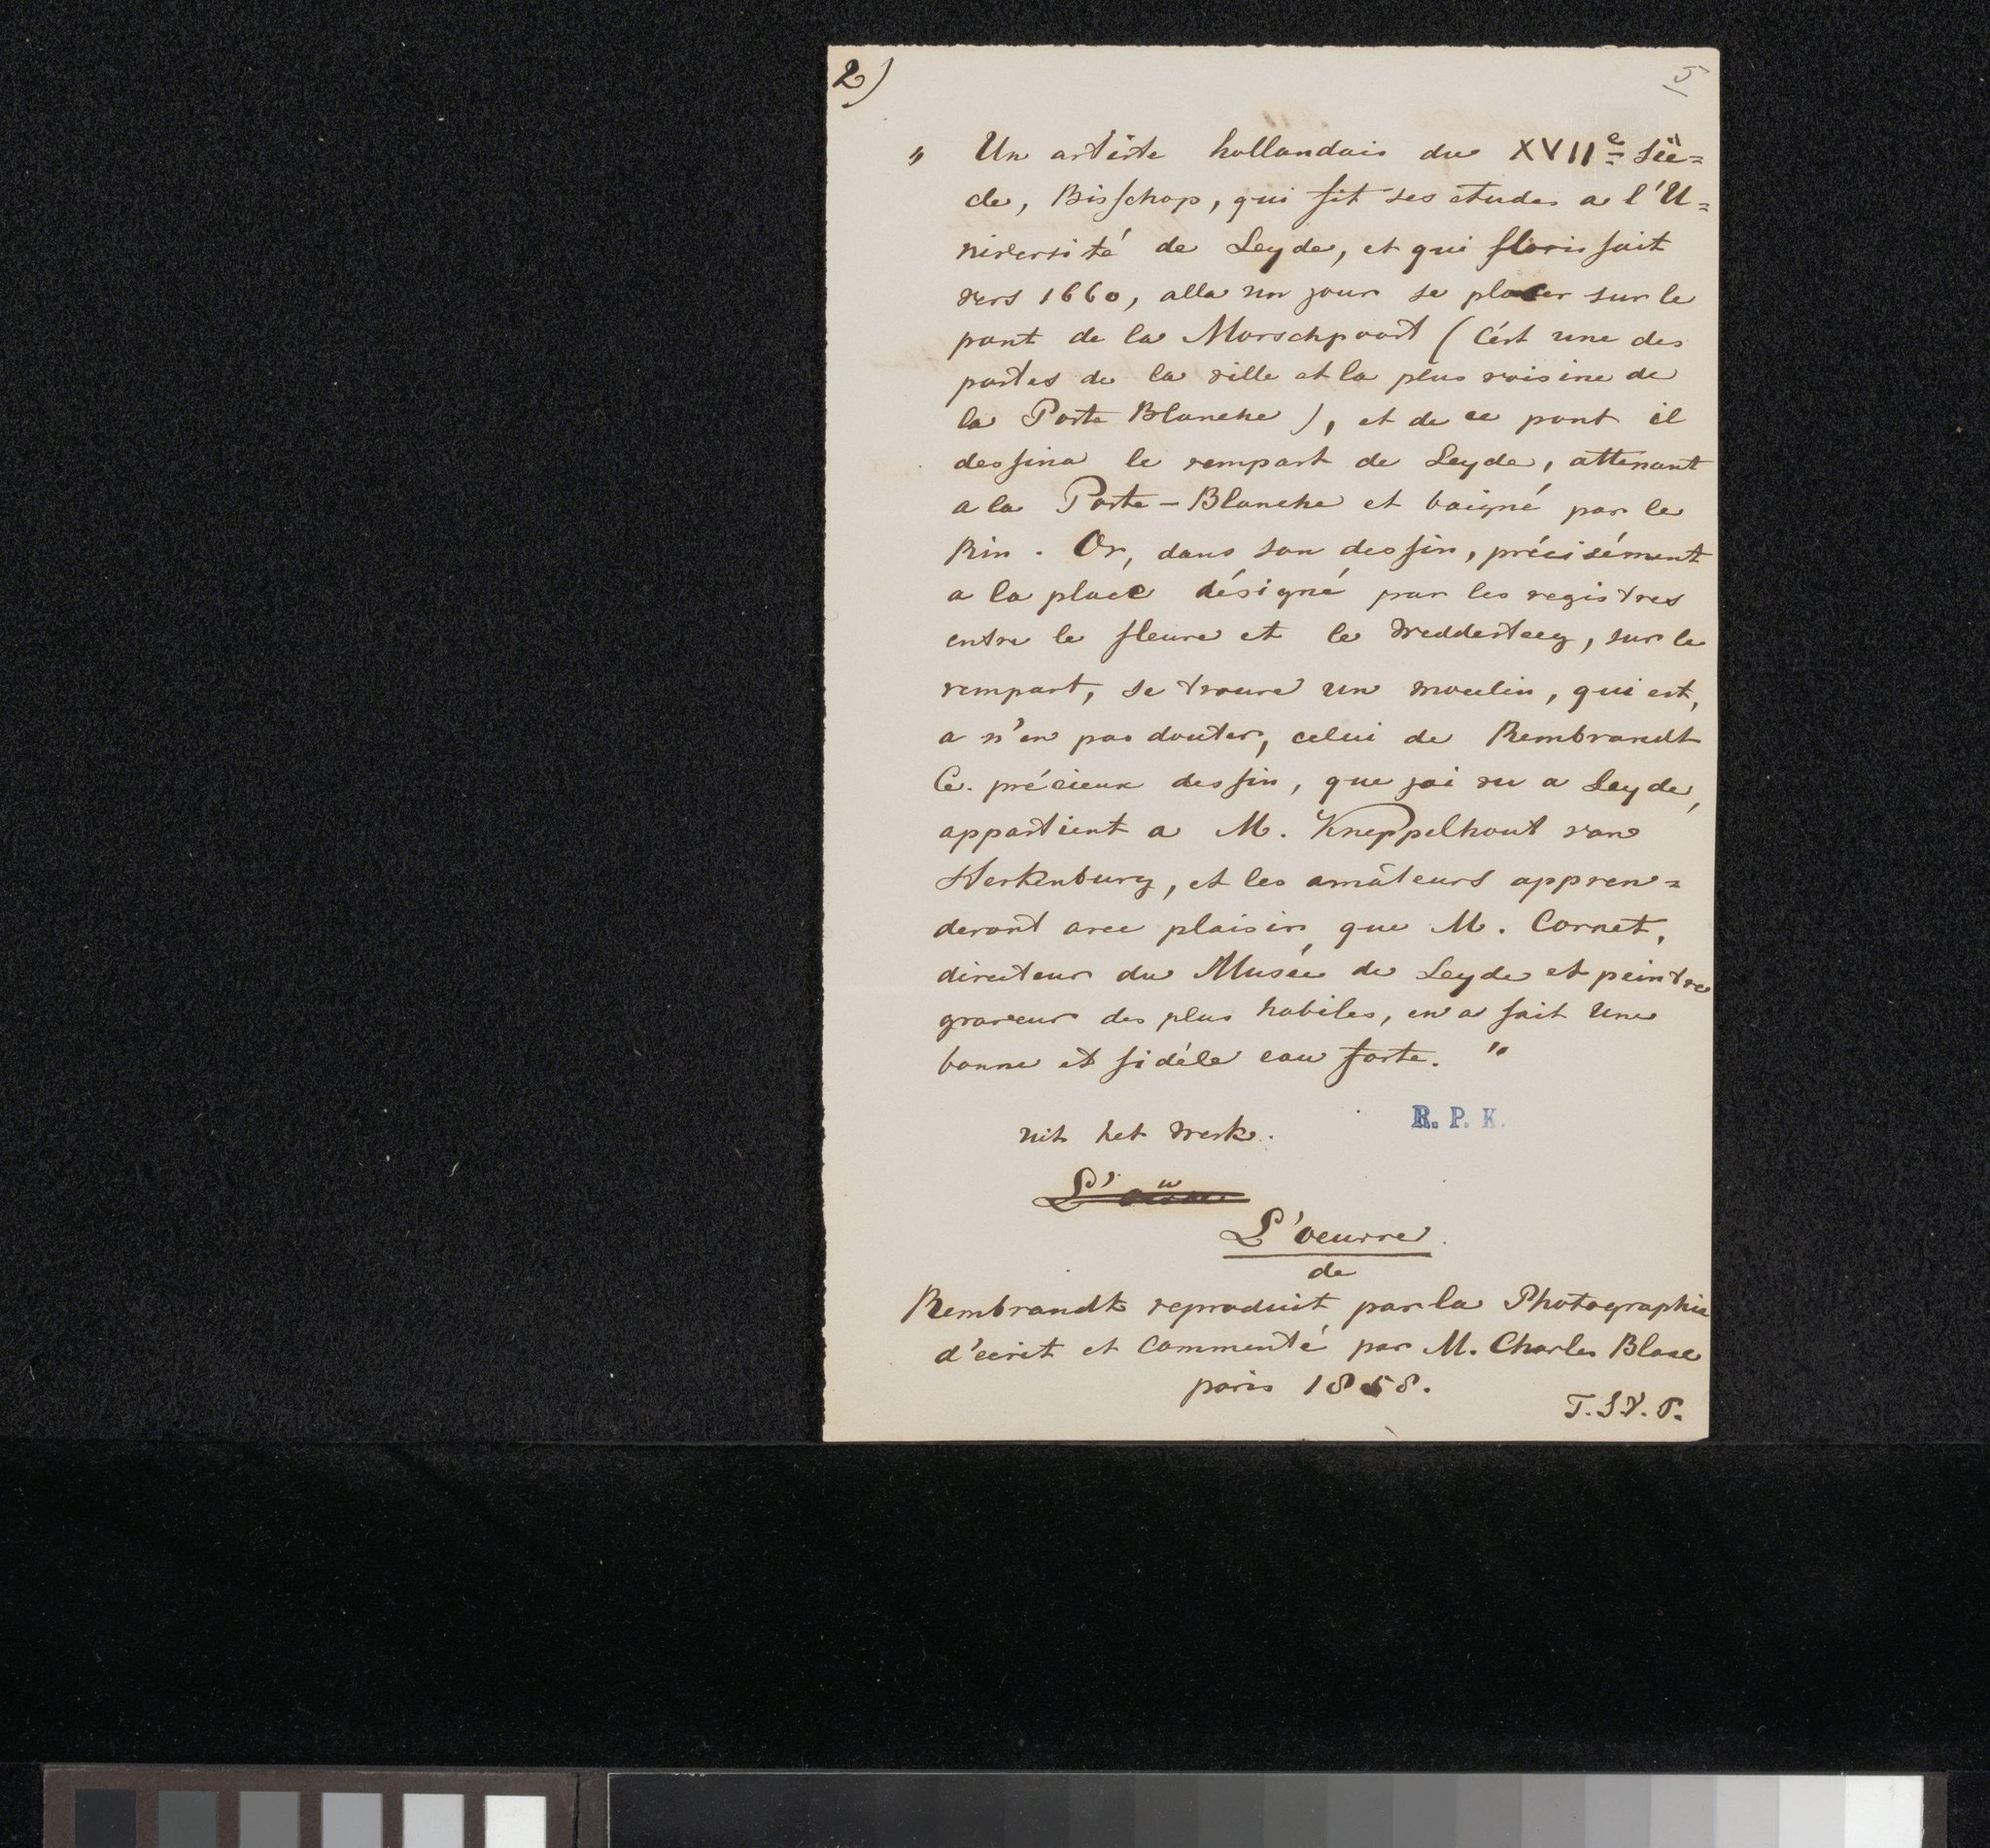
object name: aantekening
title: Aantekening betreffende Rembrandt Harmensz. van Rijn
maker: jacobus ludovicus cornet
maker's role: draughtsman, print maker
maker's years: 1815-1882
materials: ink, paper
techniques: pen, writing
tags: leiden, amsterdam, painter, print maker, draughtsman, rembrandt van rijn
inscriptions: collector's mark: Lugt 2233